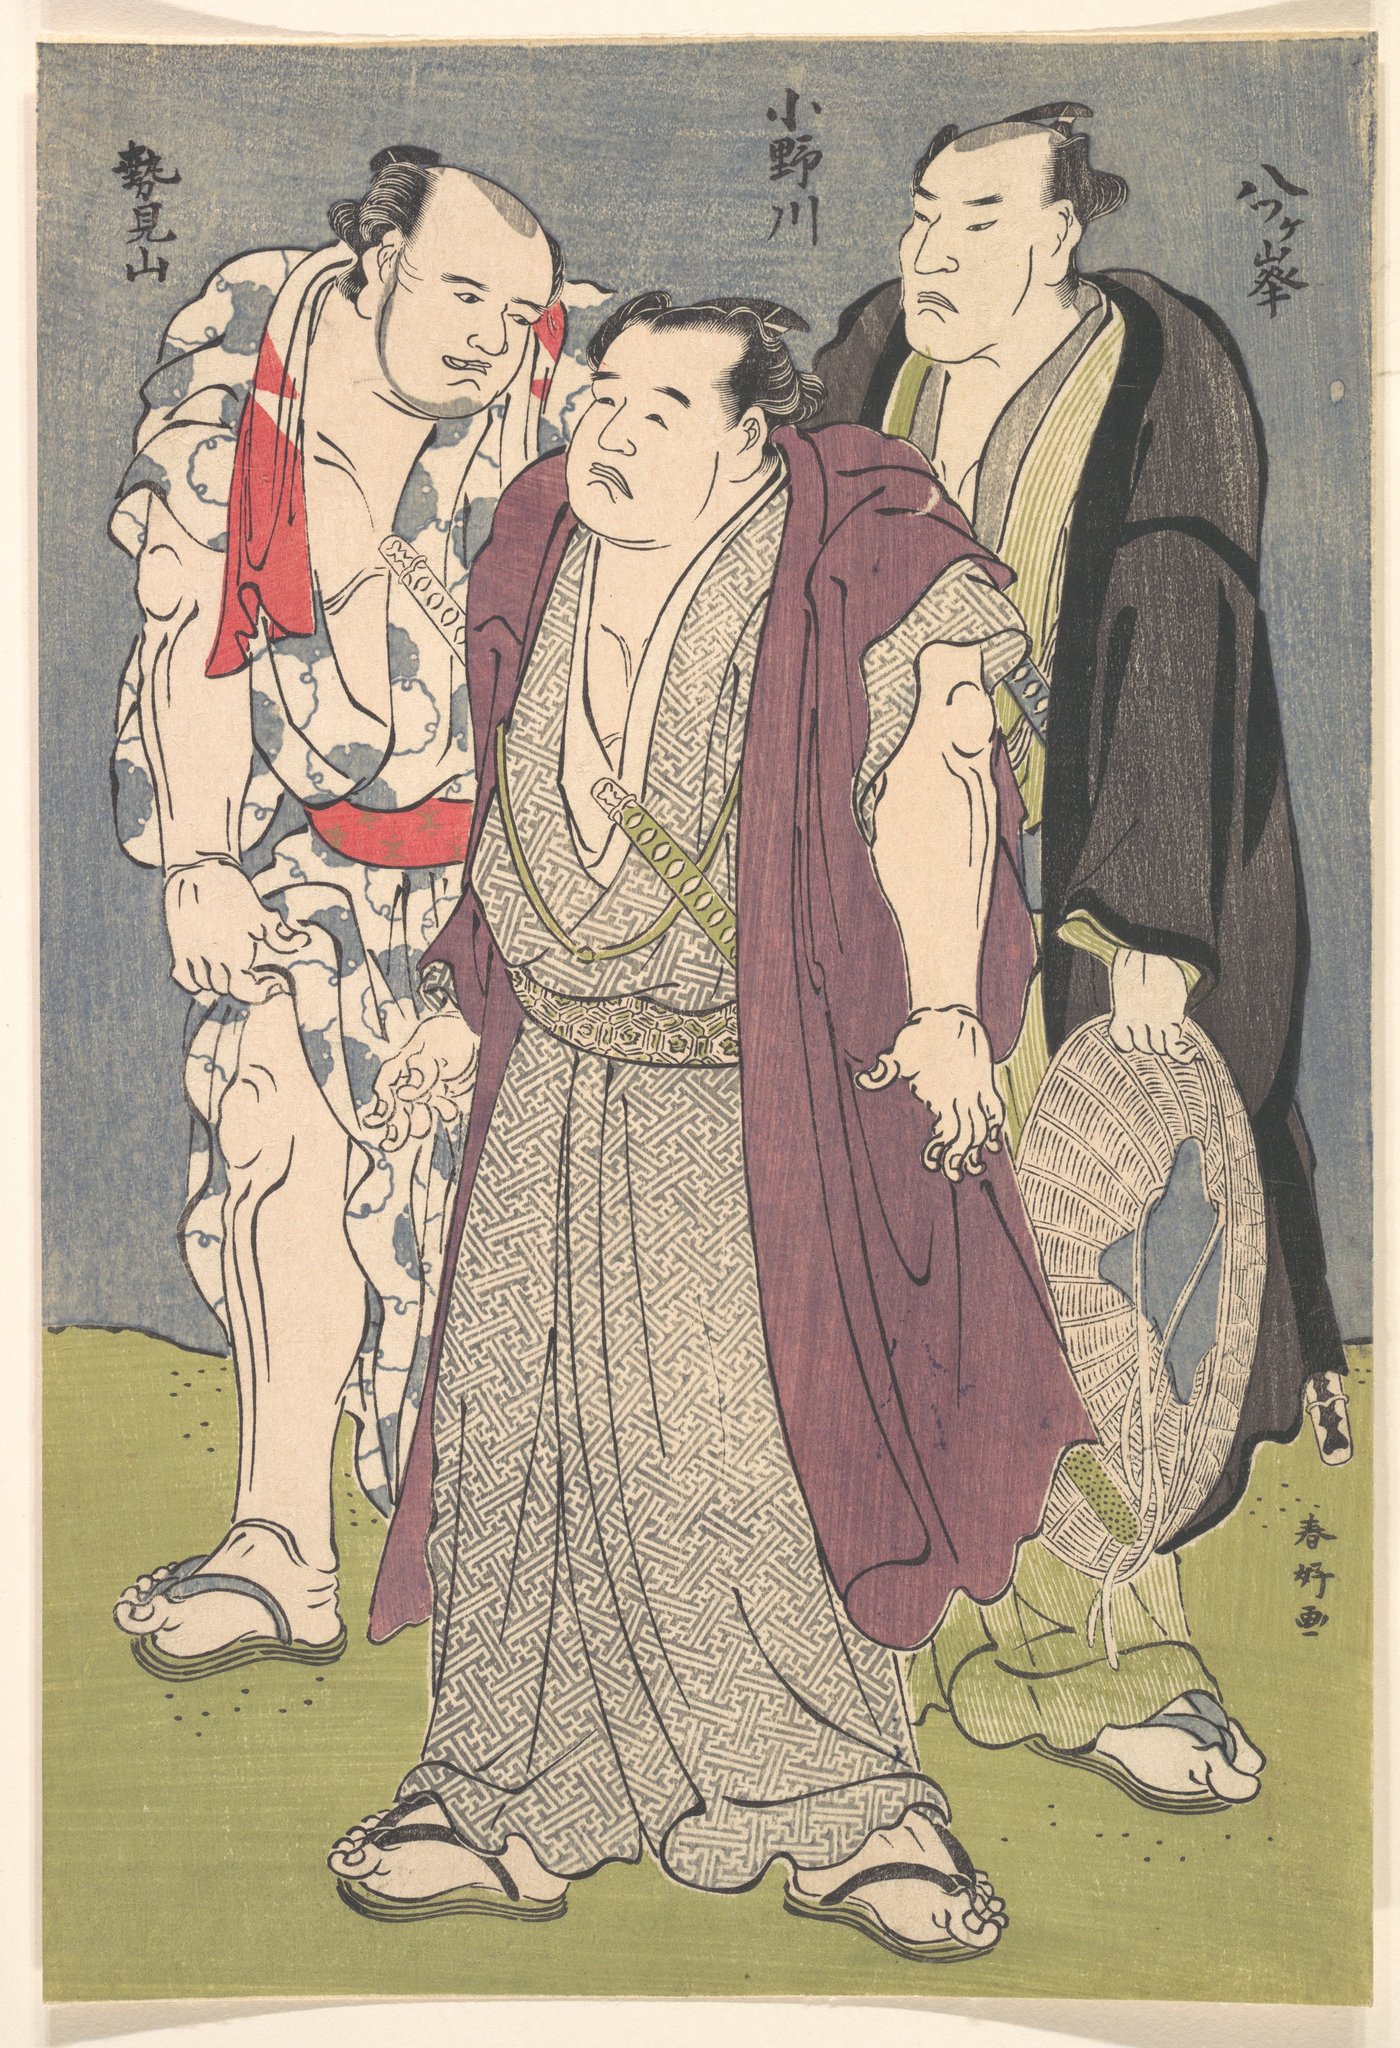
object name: print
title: Three Sumō Wrestlers: Onogawa, Seimiyama, and Yatsugamine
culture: japanese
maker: katsukawa shunkō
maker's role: artist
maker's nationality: japanese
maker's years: 1743-1812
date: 1790-1799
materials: ink, paper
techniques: woodblock print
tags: men